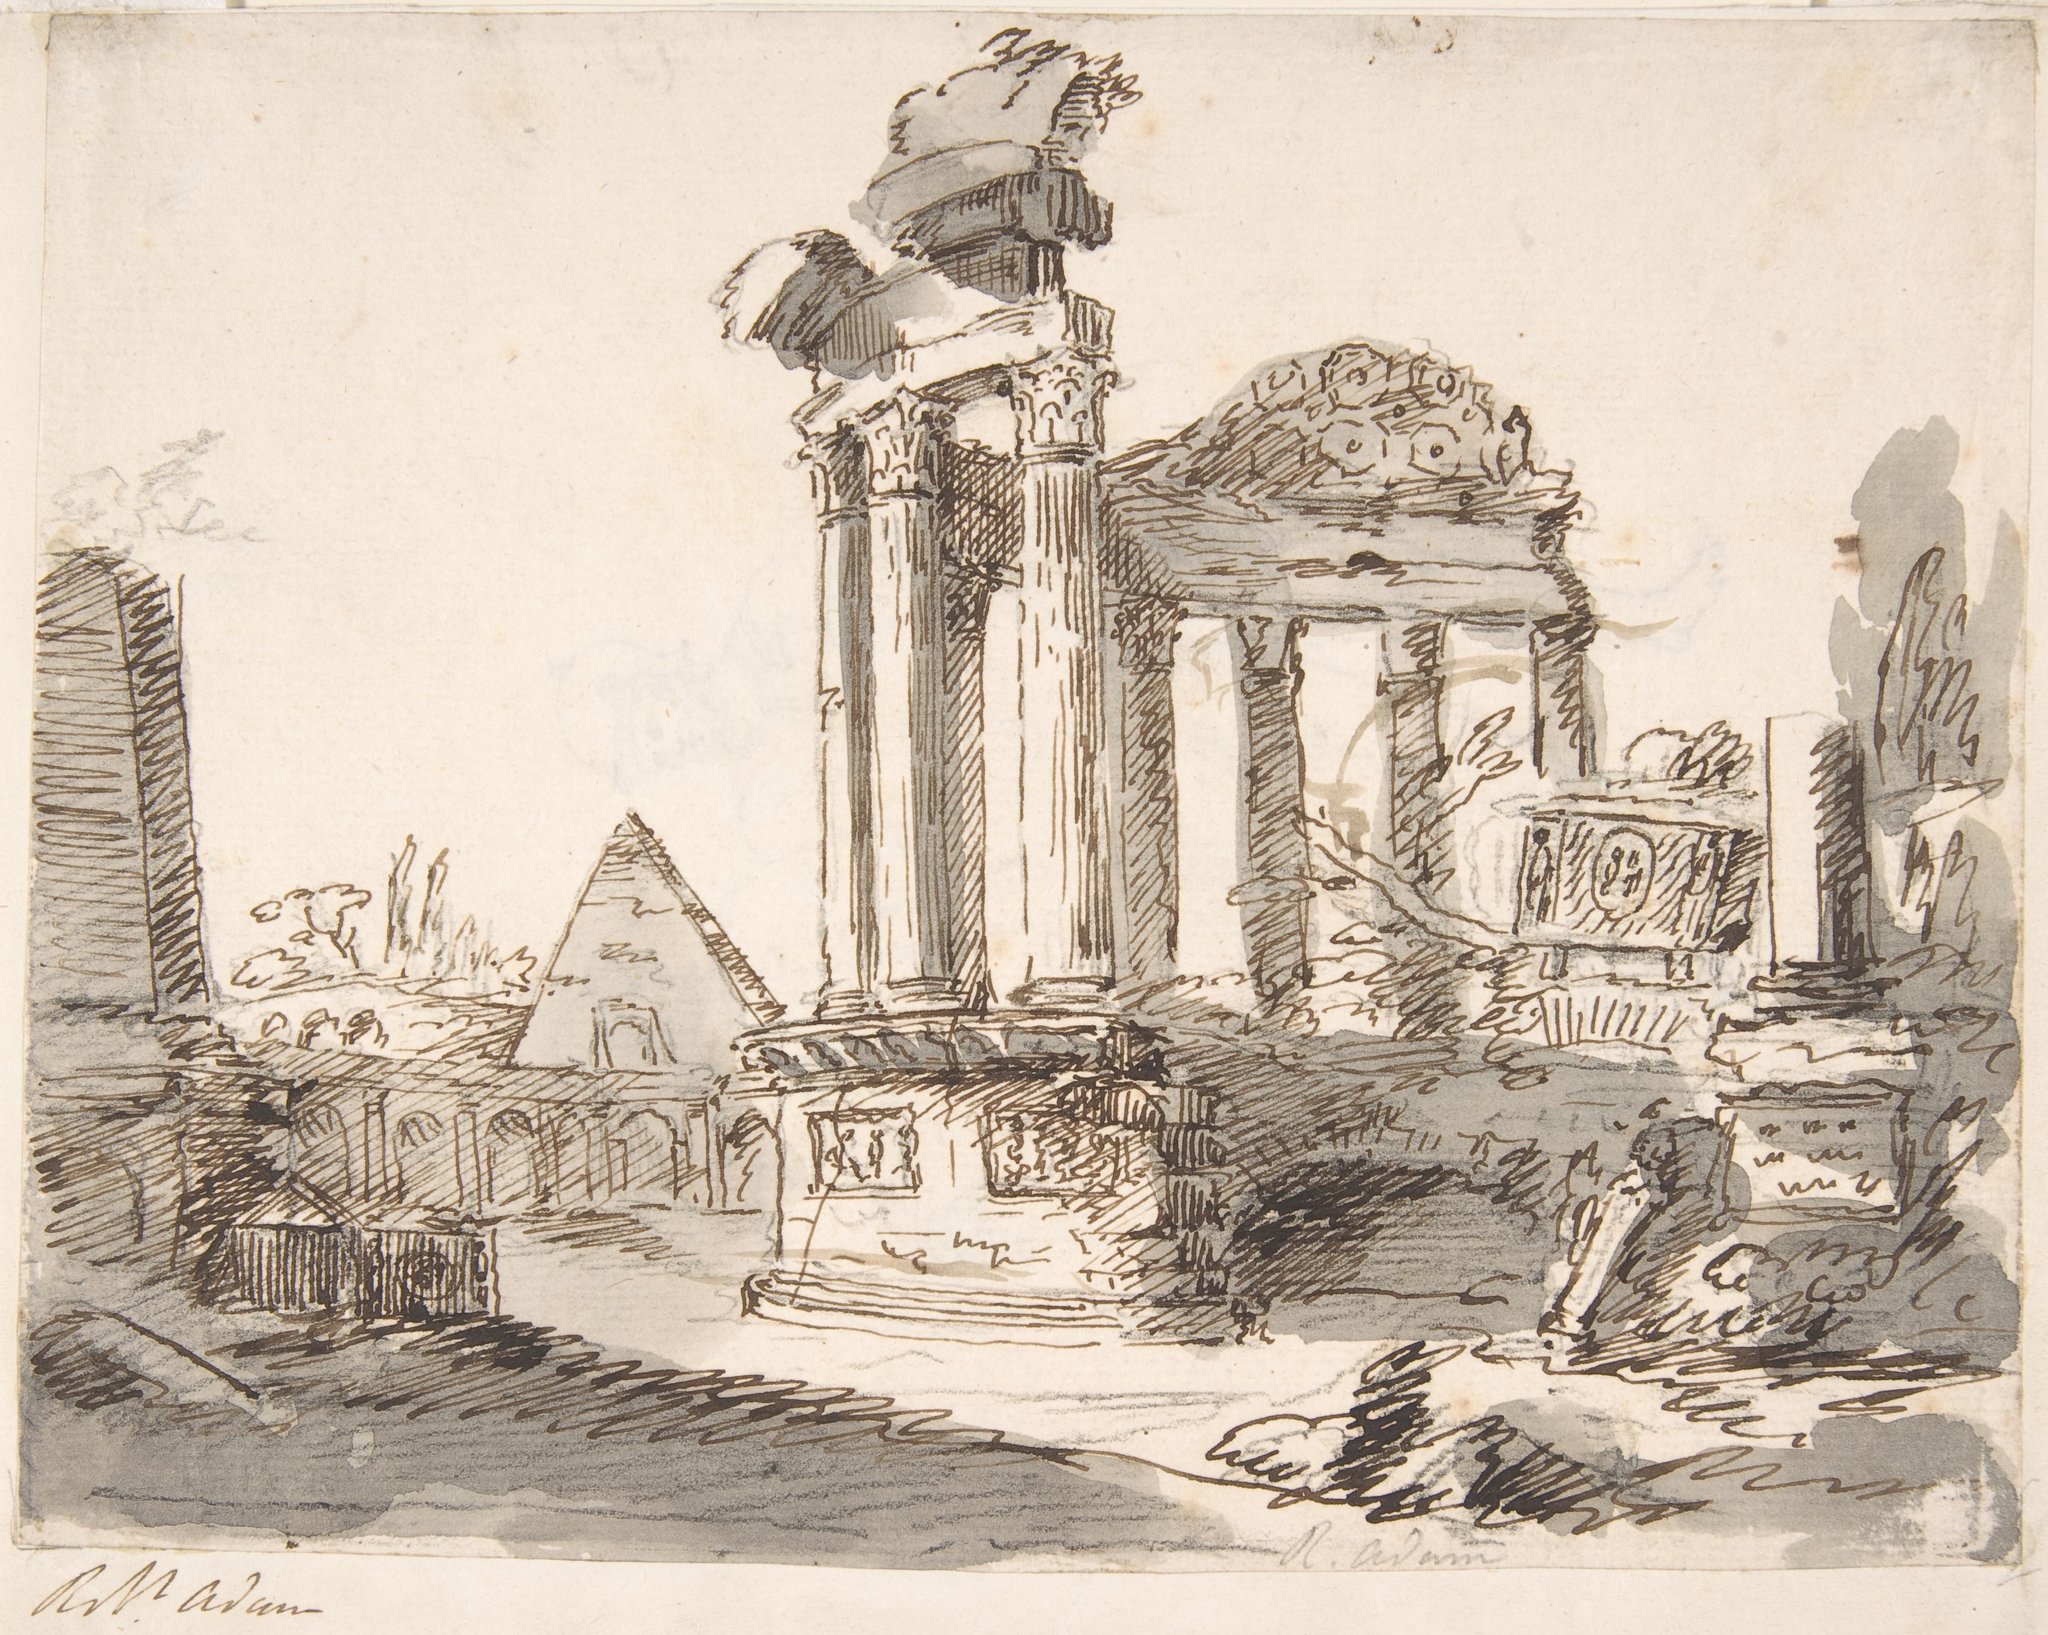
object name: drawing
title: Classical Landscape with Ruins (recto); Two men in Roman military dress (verso)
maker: robert adam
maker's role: artist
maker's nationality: british, scottish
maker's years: 1728-1792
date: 1755-1757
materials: chalk, ink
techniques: brush, pen, wash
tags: ruins,military clothing,men,landscapes